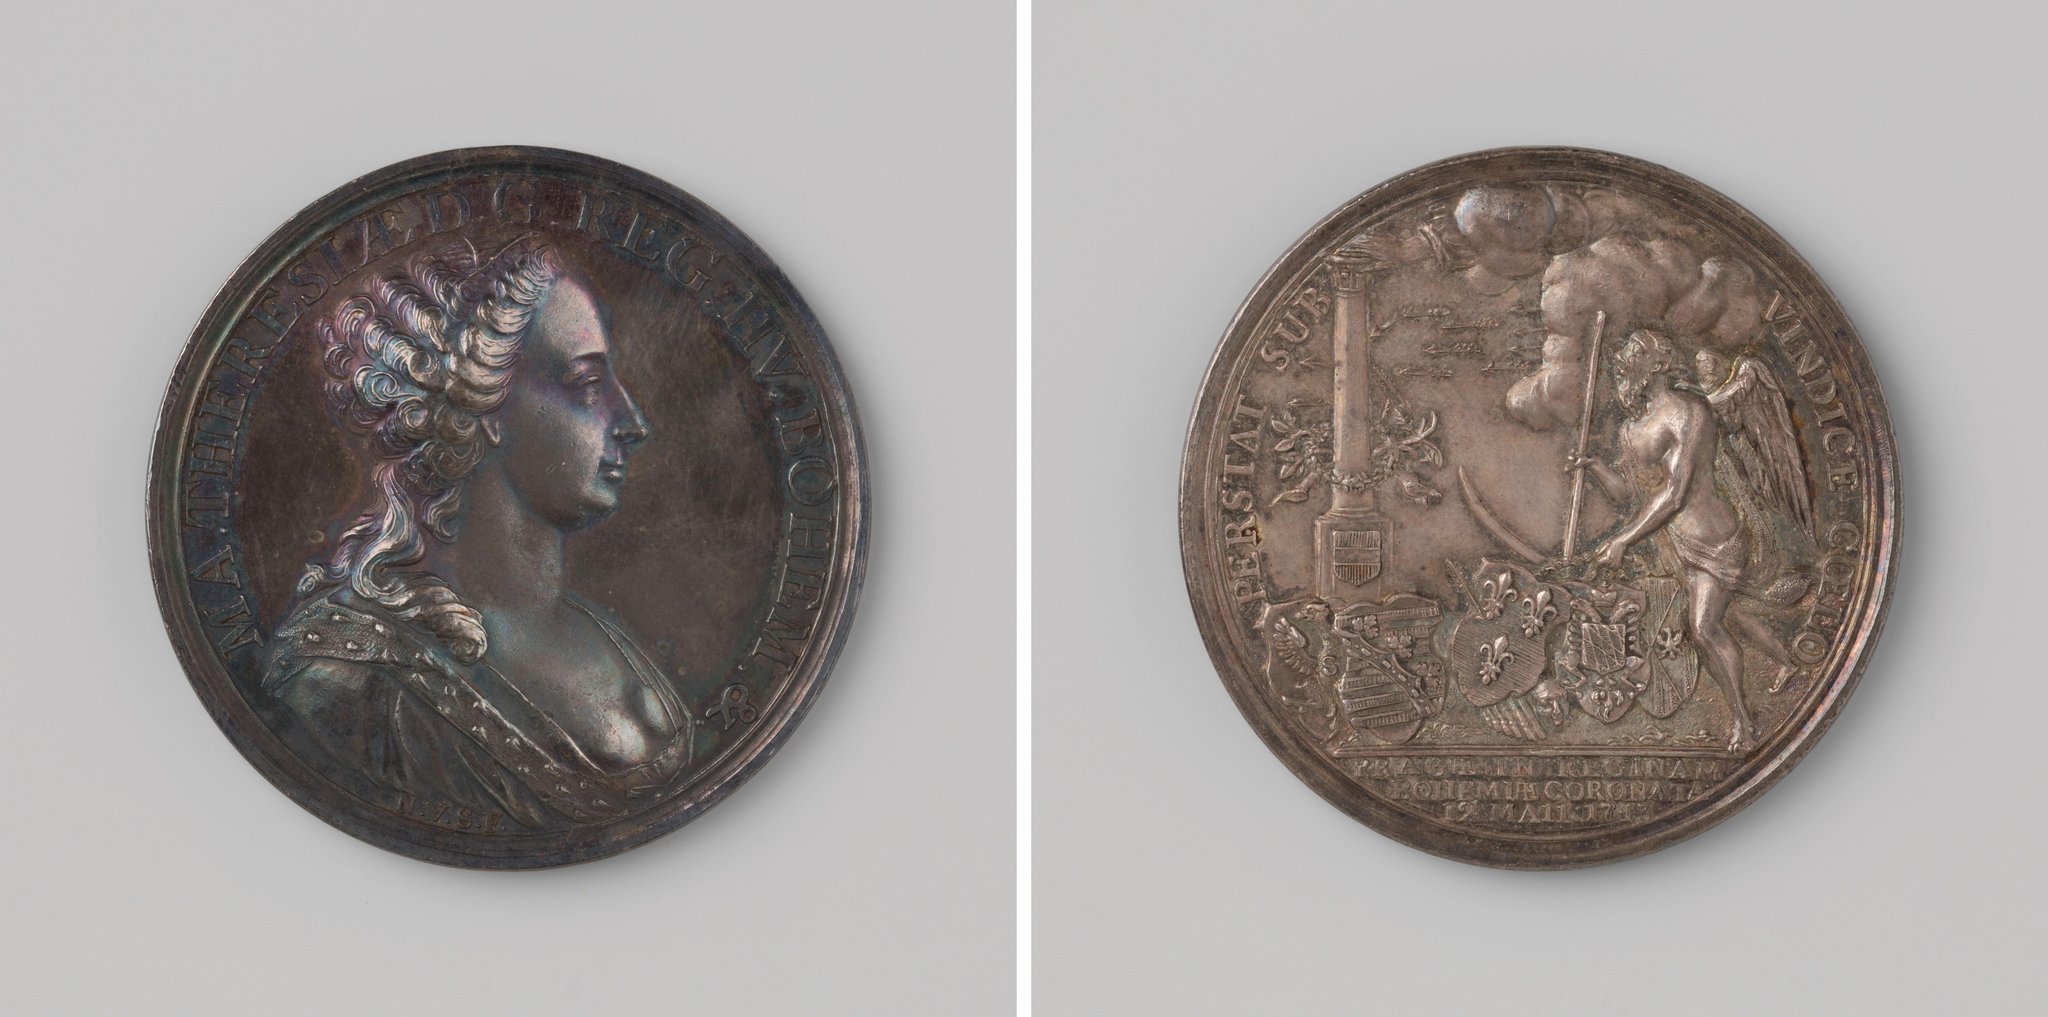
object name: history medal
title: Kroning van Maria Theresia tot koningin van Bohemen te Praag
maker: nicolaas van swinderen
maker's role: jeweler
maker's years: 1705-1760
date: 1743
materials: silver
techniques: striking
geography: the hague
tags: vienna, maria theresia (rooms-duits keizerin), prague